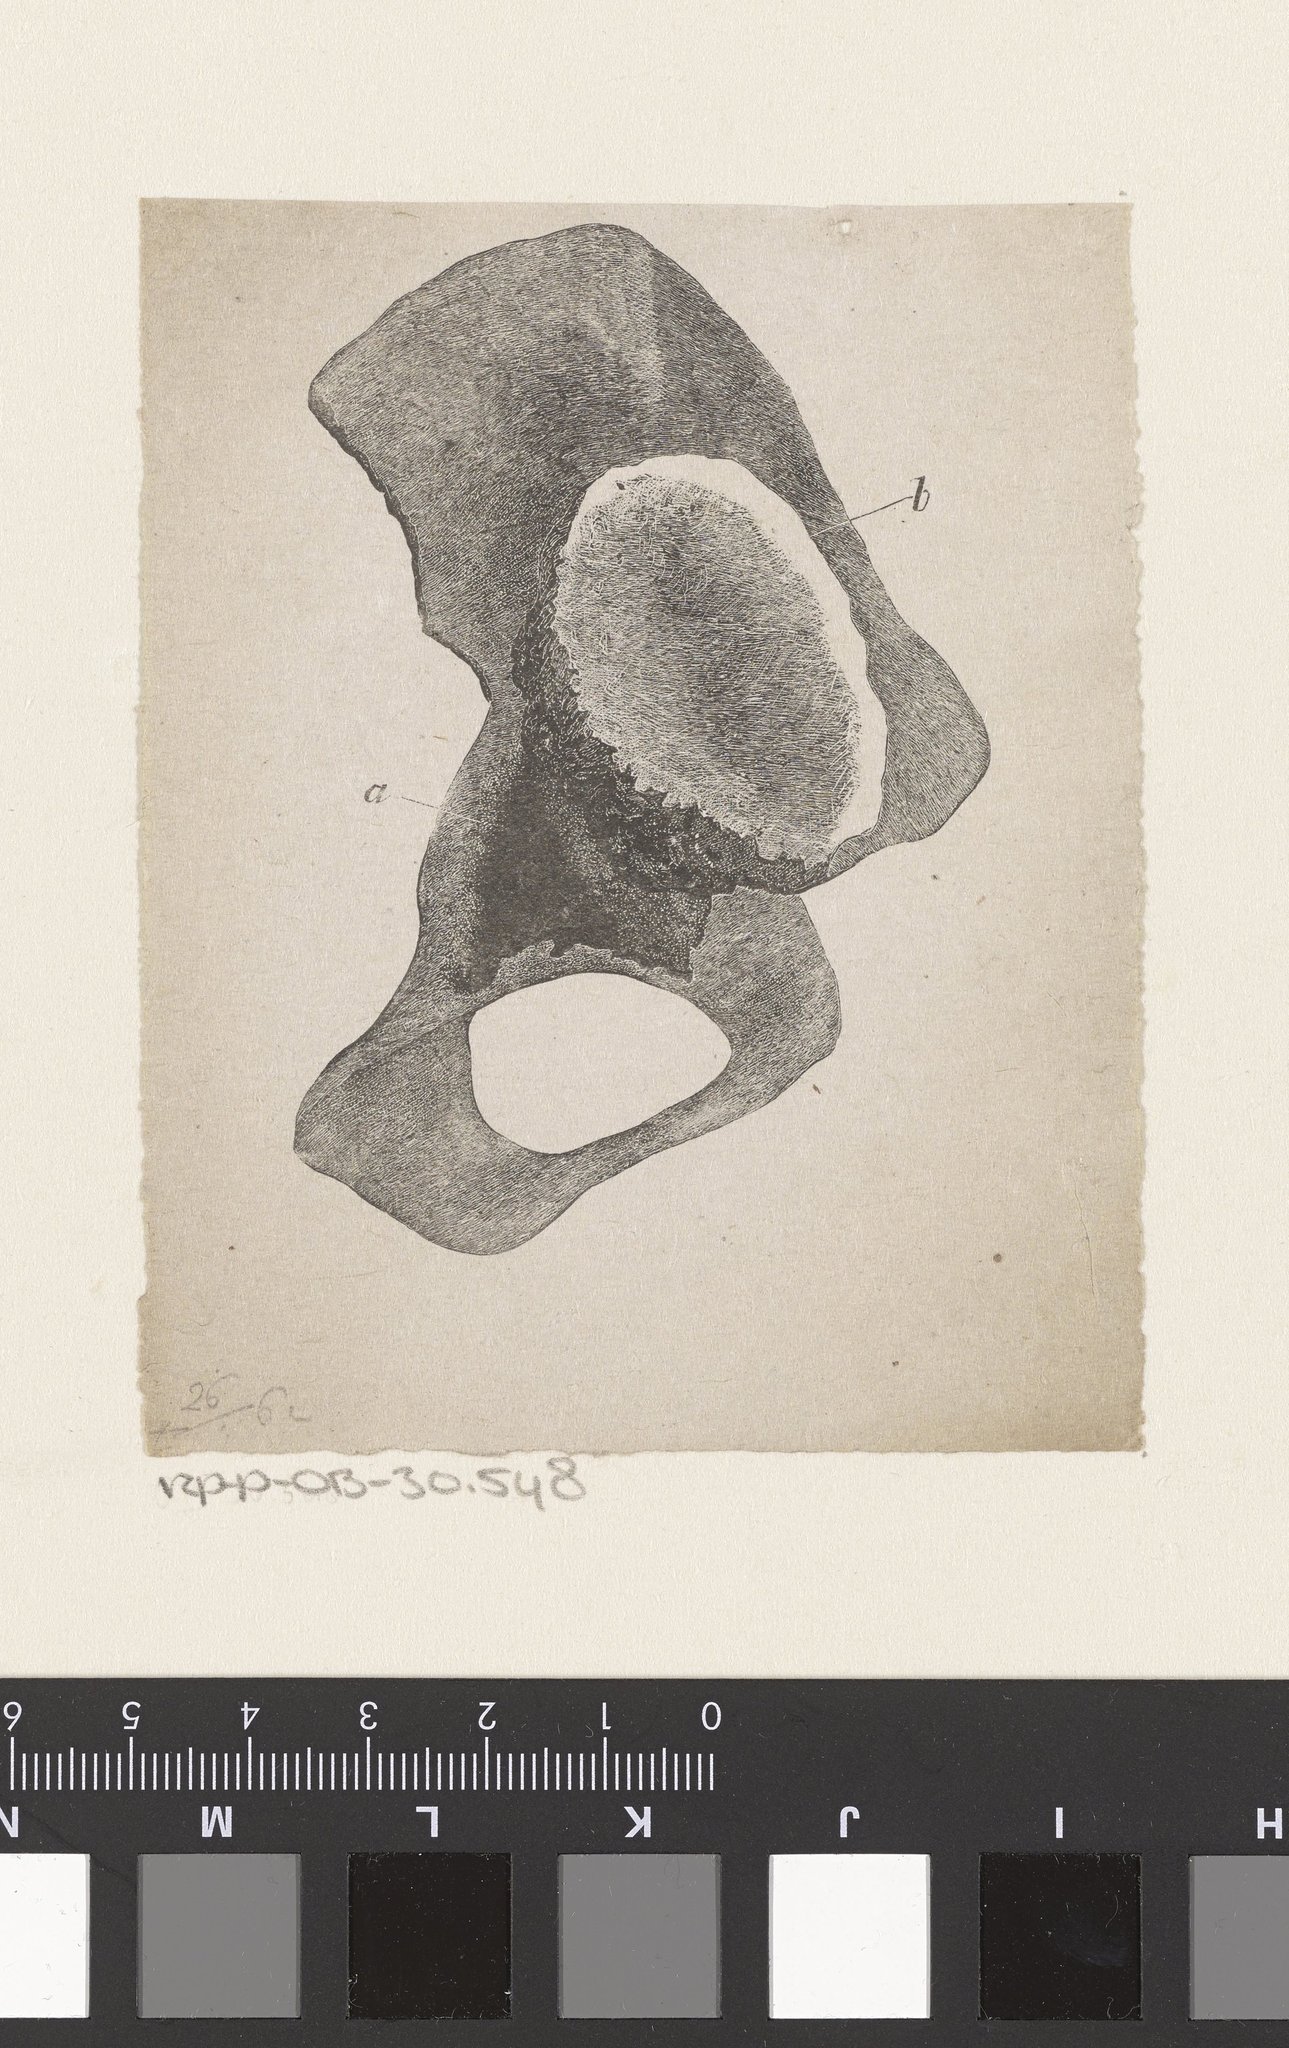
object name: print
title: Menselijk bot met een afwijking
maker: isaac weissenbruch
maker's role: print maker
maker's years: 1826-1912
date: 1836-1912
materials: paper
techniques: engraving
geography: netherlands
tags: bones in general (human body), diseases